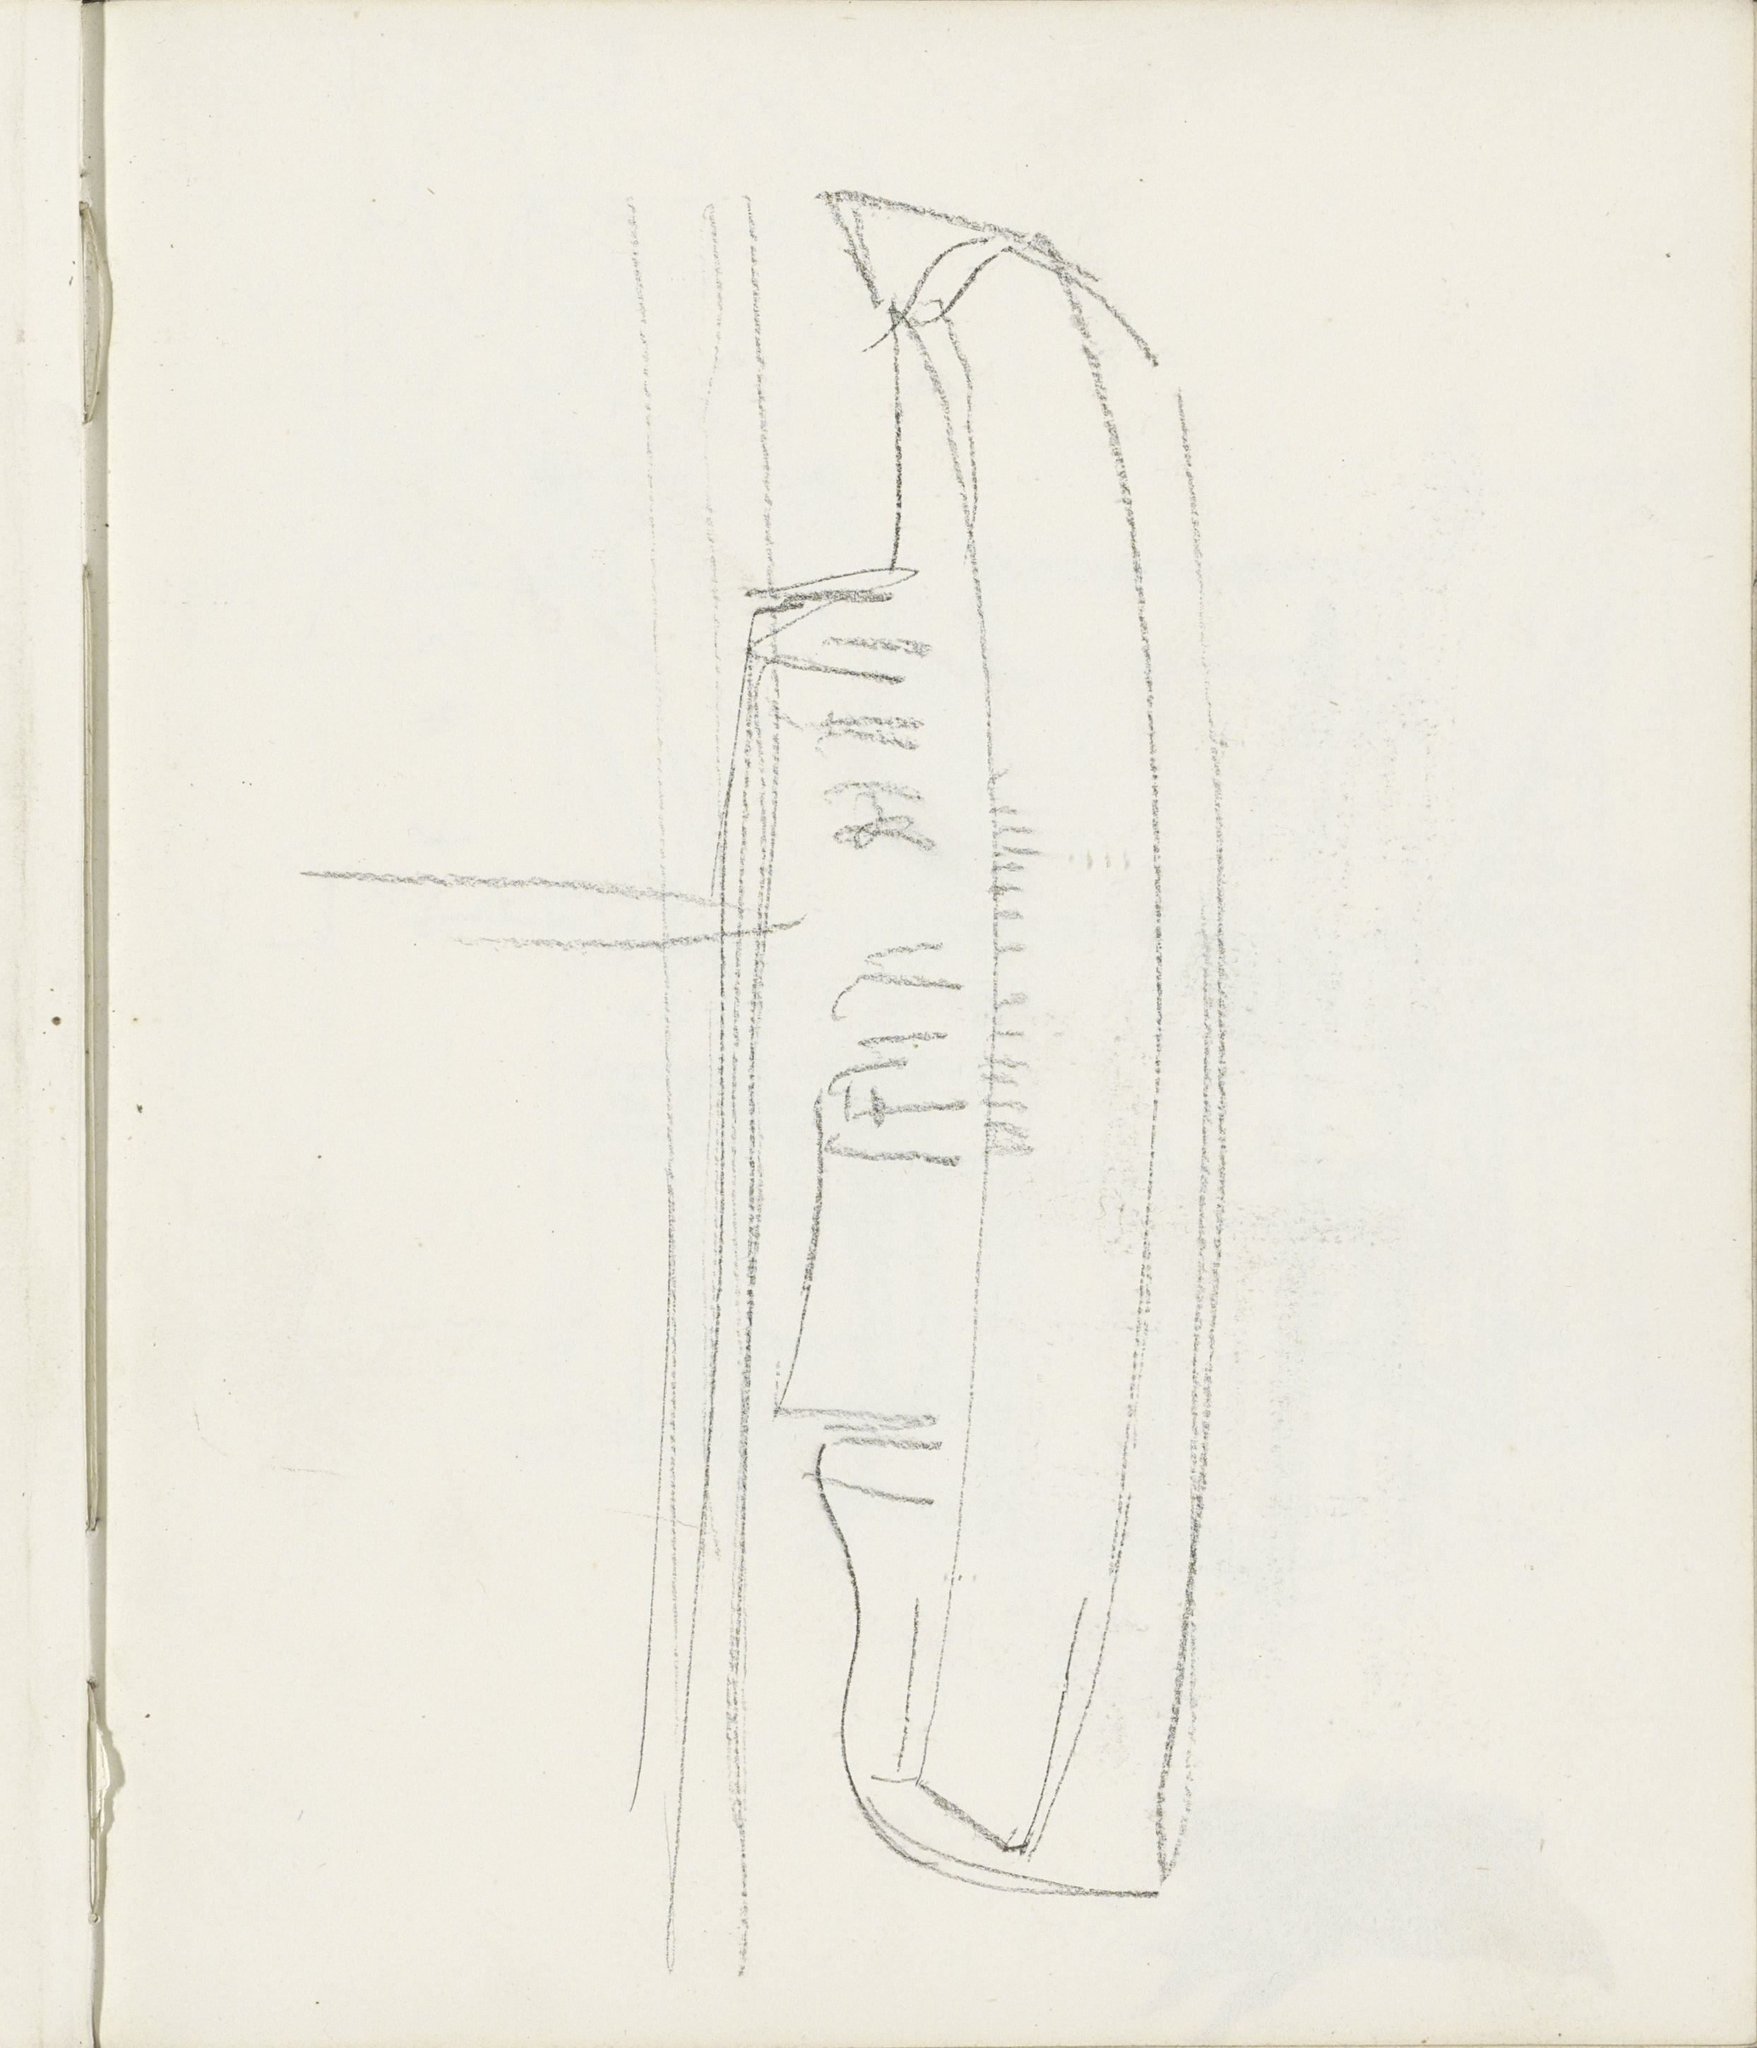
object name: sketchbook leaf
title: Boot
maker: carel adolph lion cachet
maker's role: draughtsman, print maker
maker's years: 1864-1945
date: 1900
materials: chalk, paper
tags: sailing-ship, sailing-boat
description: Blad 9 recto uit een schetsboek met 15 bladen.